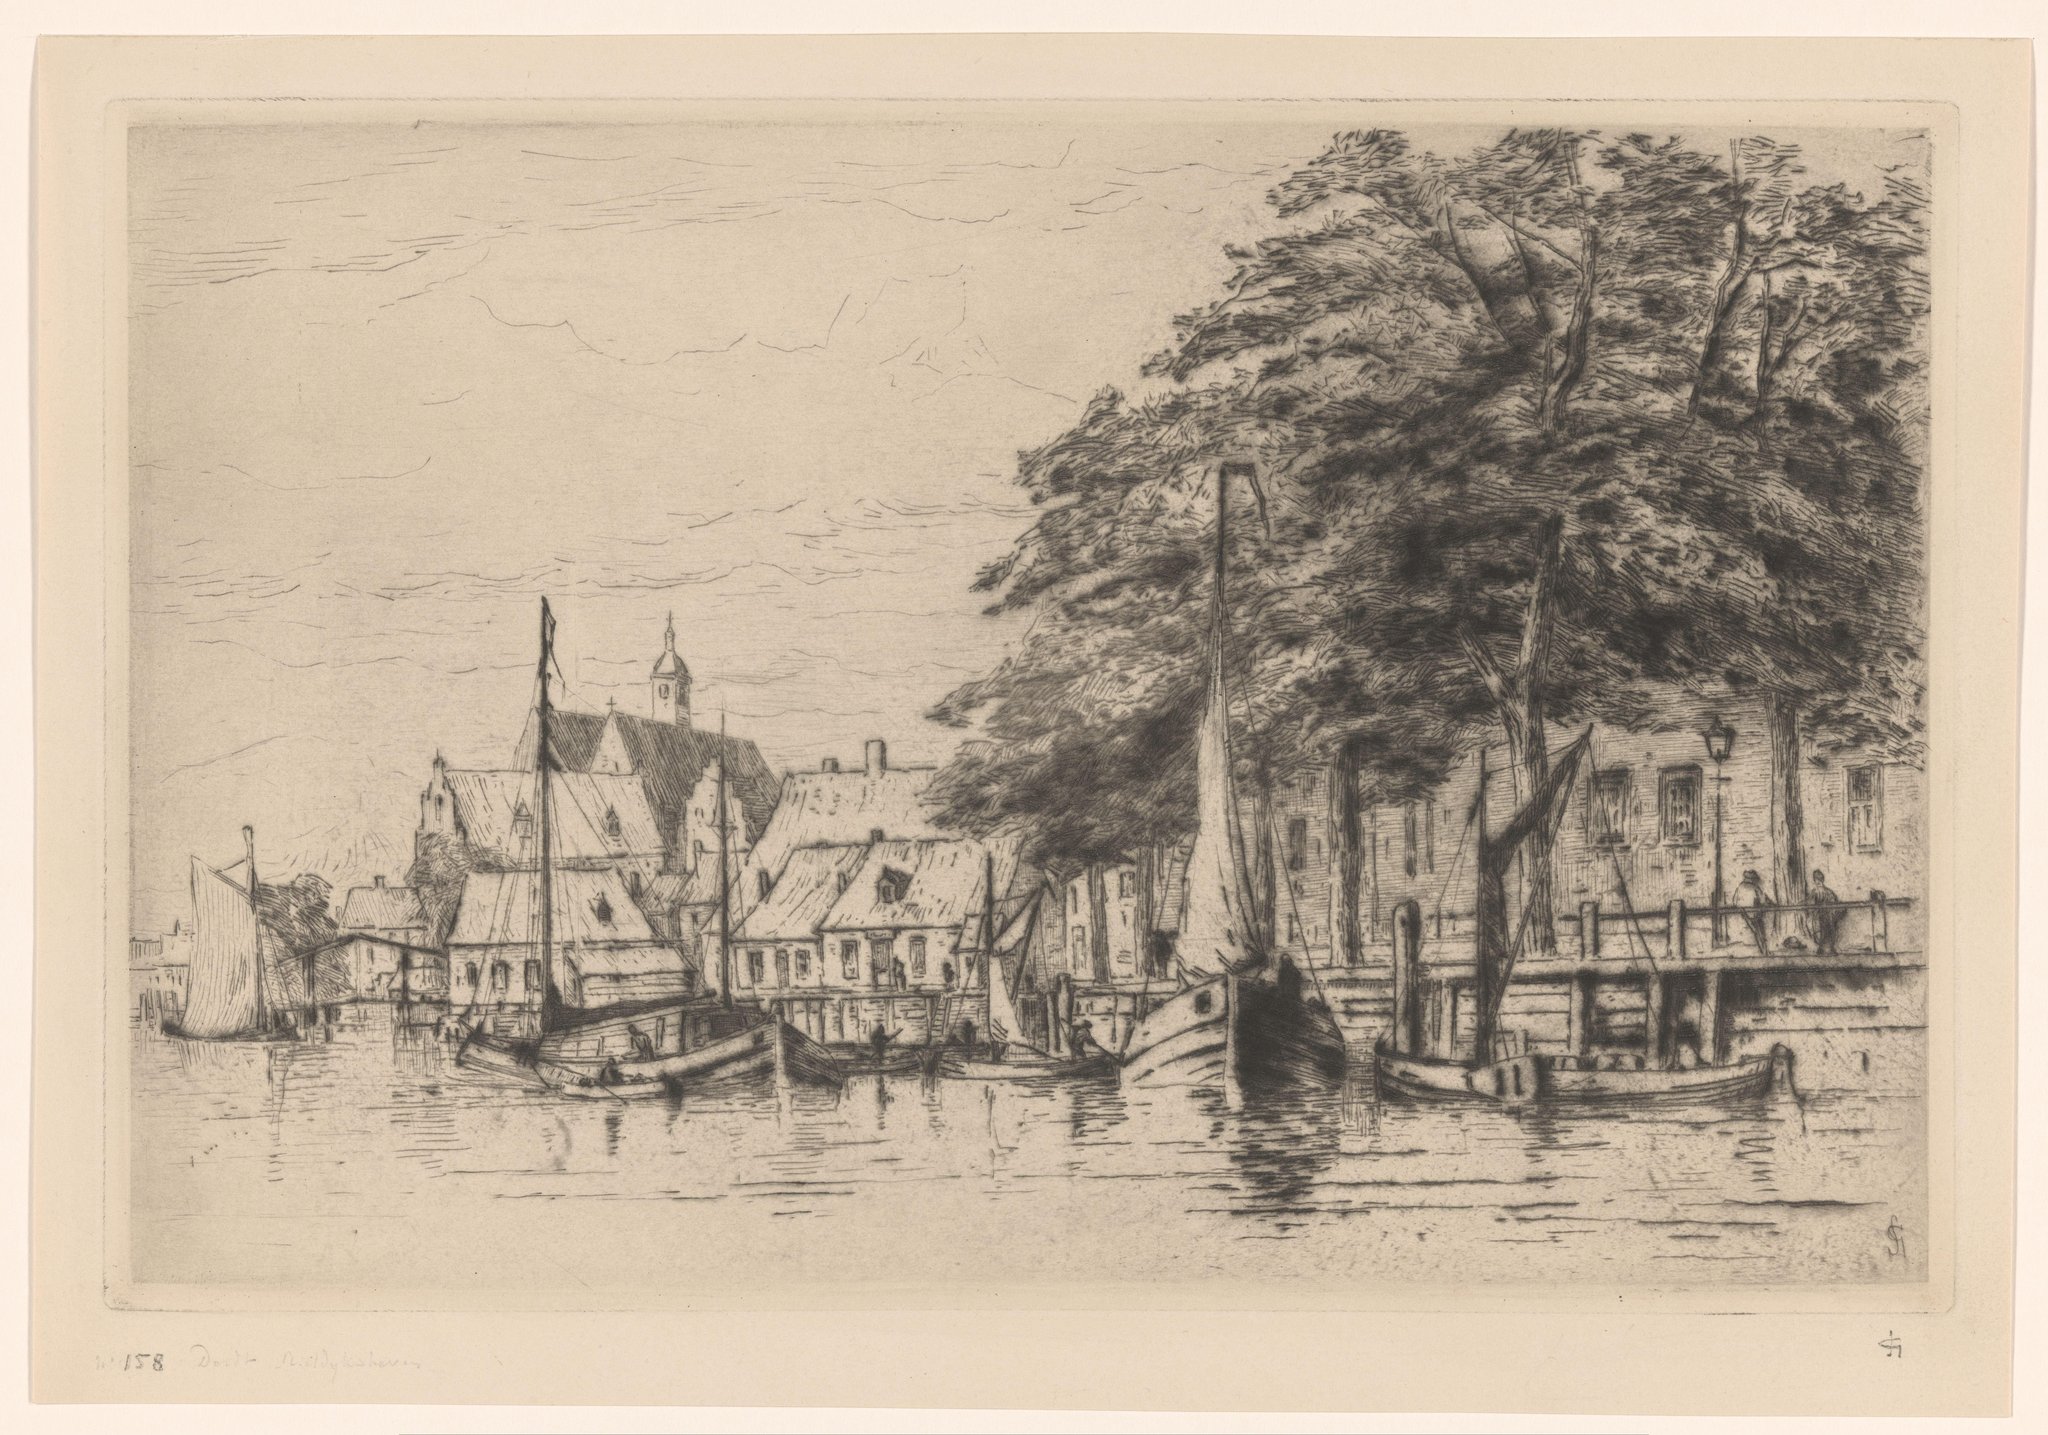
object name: print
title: Dordrecht. Bietdykshaven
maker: carel nicolaas storm van s-gravesande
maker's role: draughtsman, print maker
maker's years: 1841-1924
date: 1880-1884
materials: paper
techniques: drypoint, intaglio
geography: netherlands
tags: harbour, dordrecht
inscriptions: collector's mark: Lugt 2228